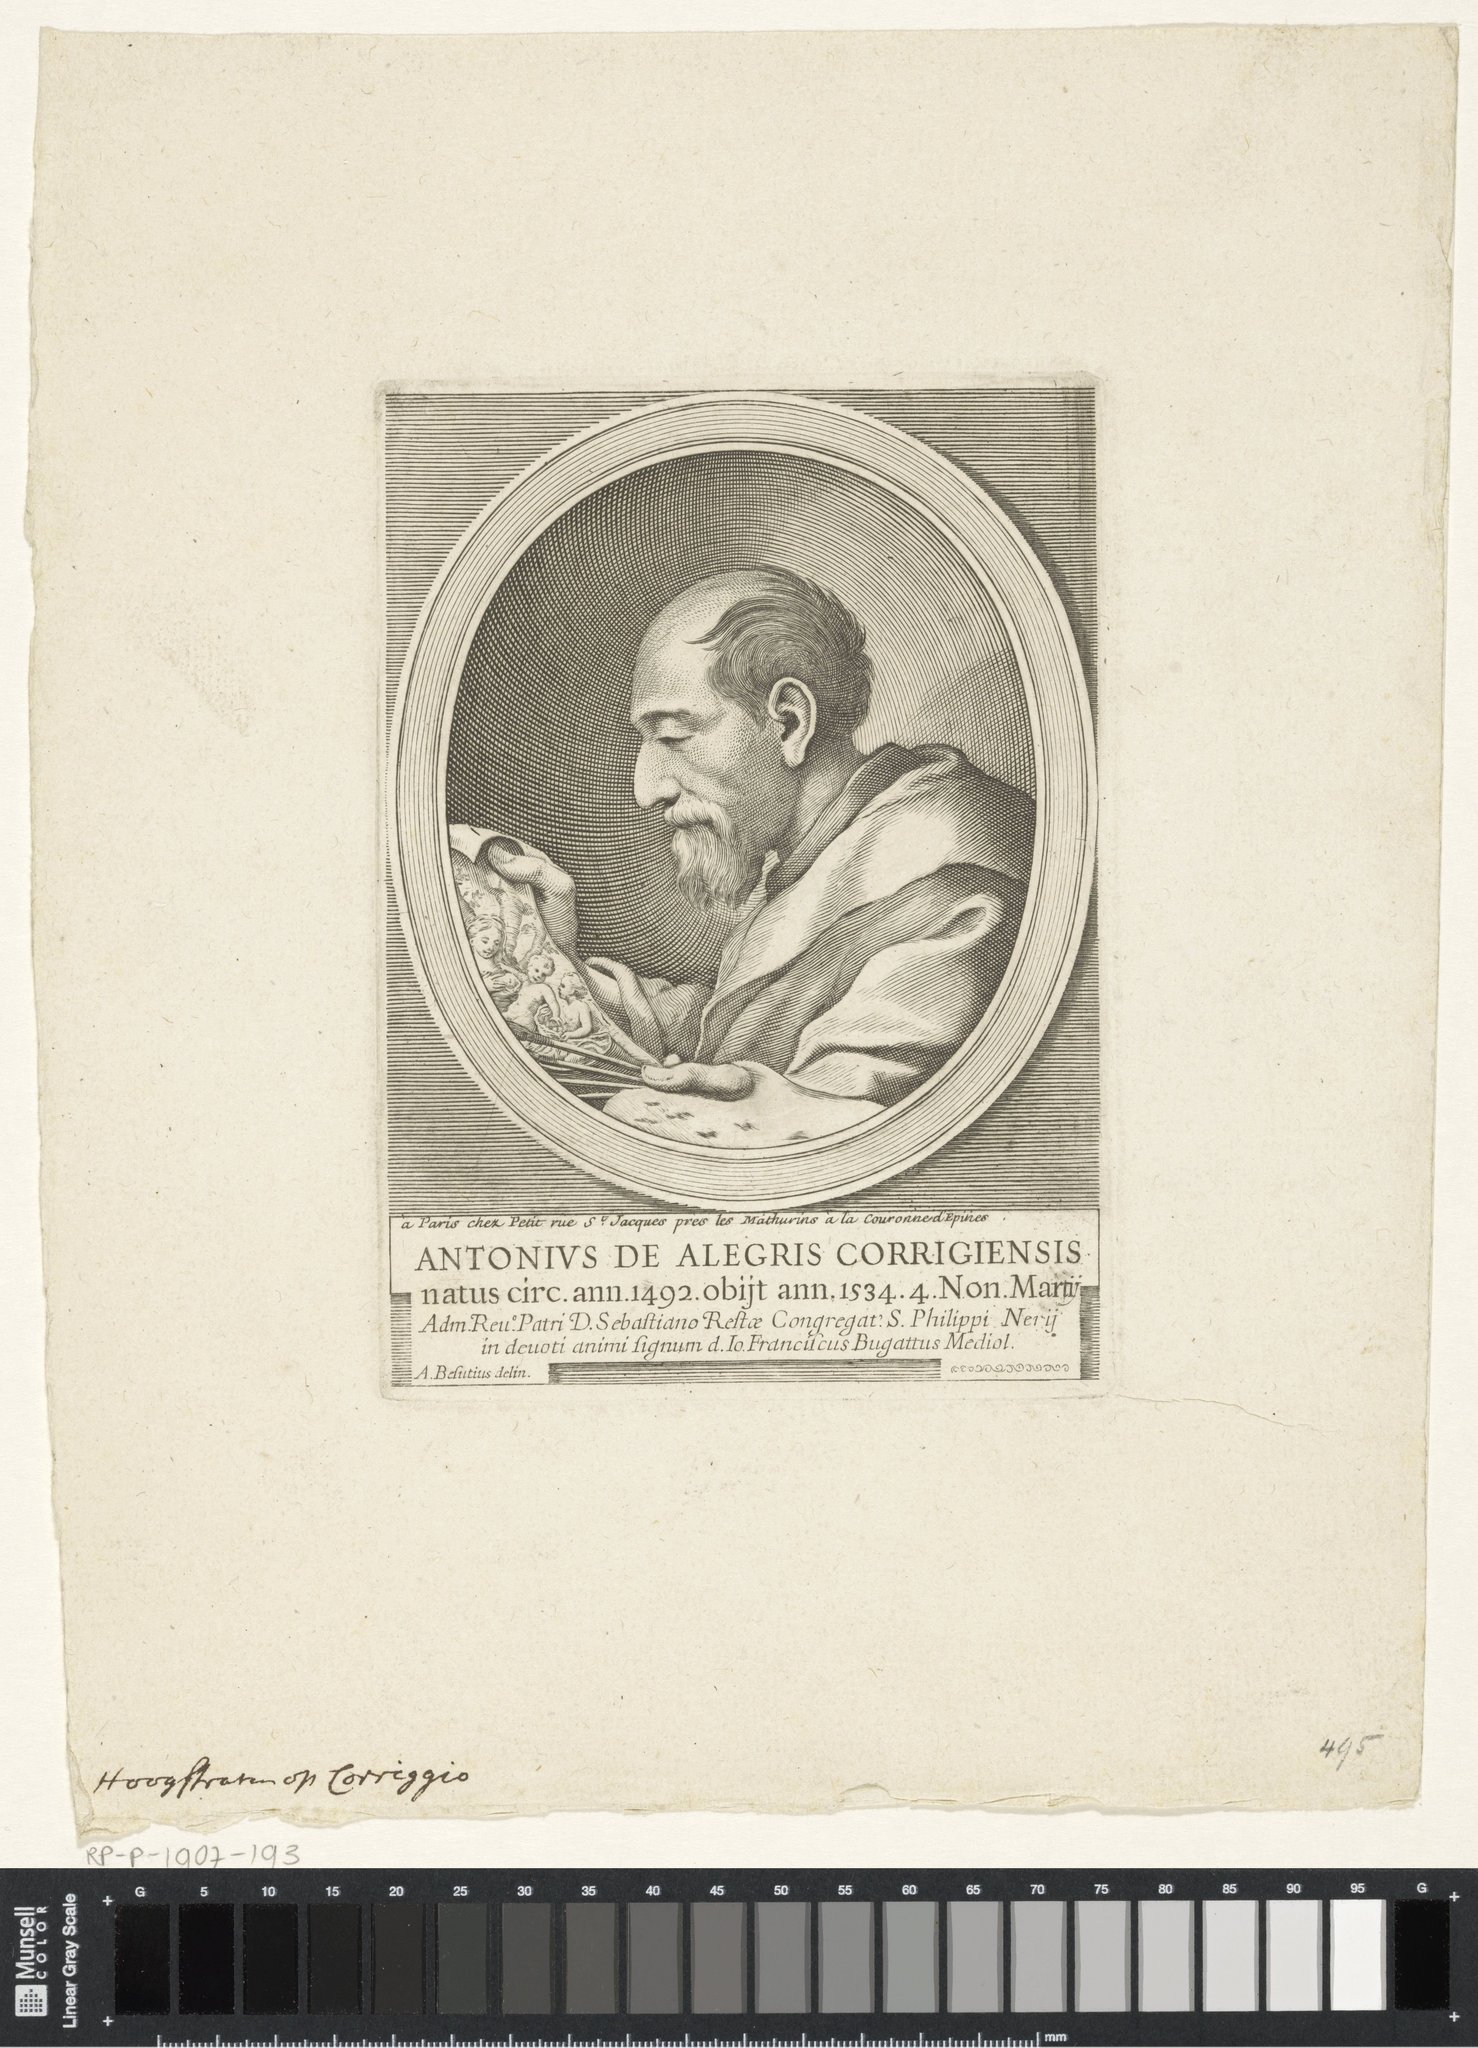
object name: print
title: Portret van de schilder Correggio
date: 1600-1699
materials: paper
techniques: engraving, etching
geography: italy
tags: painter, print maker, draughtsman, correggio, historical persons, portrait, self-portrait of artist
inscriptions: collector's mark: Lugt 2228, inscription: ‘Hoogstraten op Corrèggio’